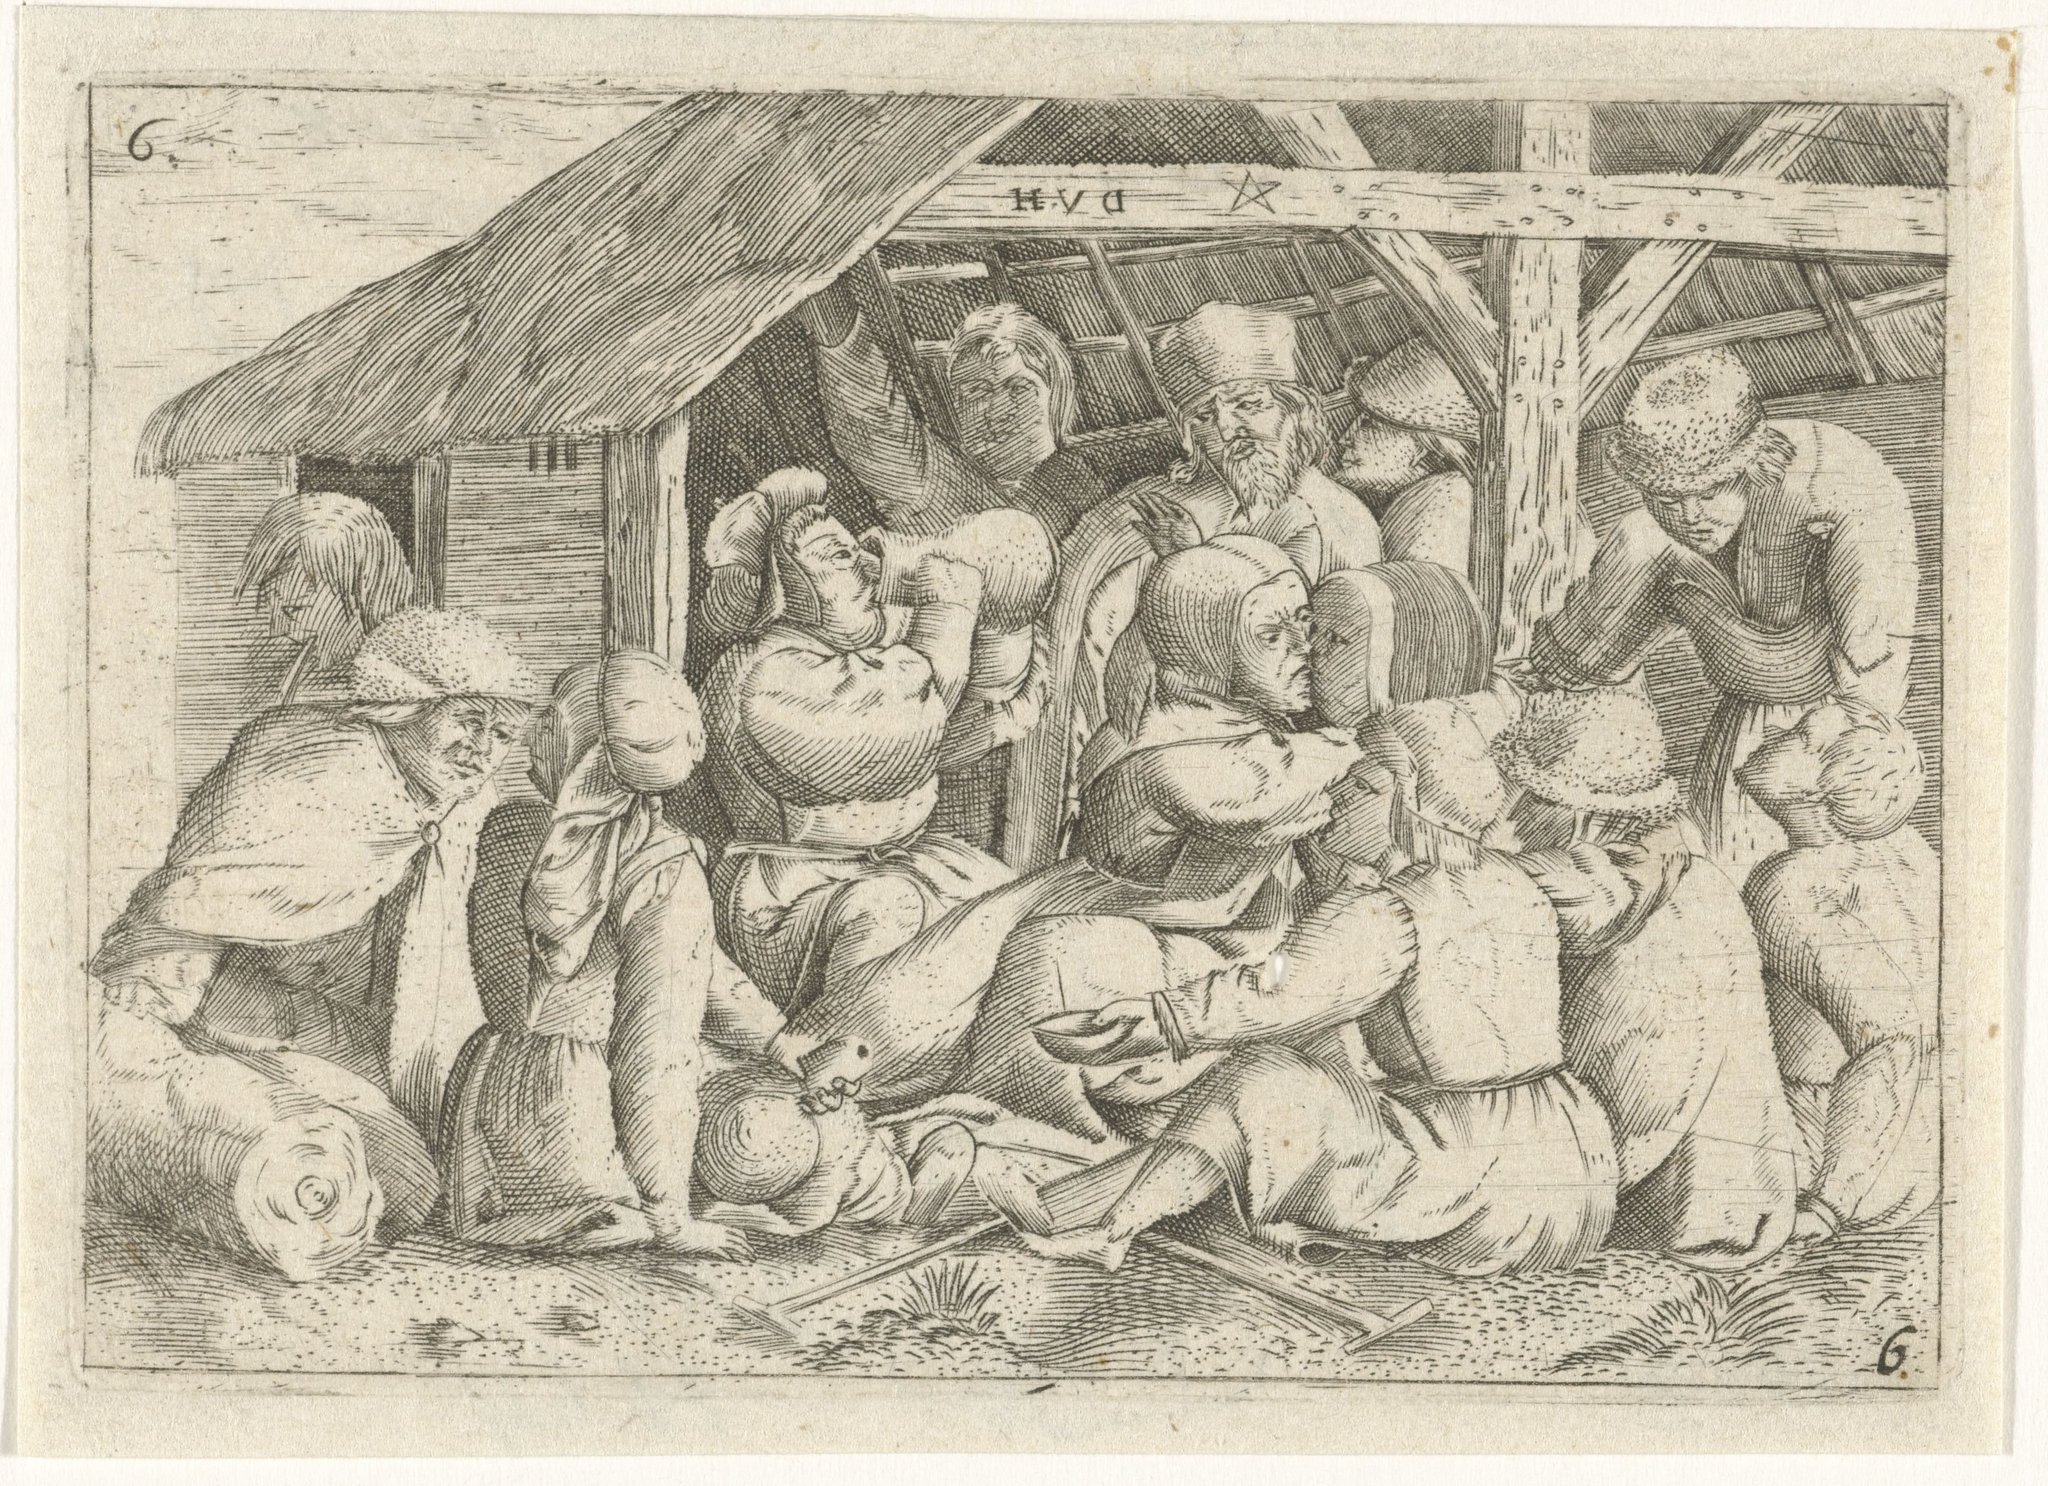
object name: print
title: Bedelaars bij een maaltijd in een hut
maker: dirk van hoogstraten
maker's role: painter, print maker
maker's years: 1596-1640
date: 1606-1640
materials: paper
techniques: engraving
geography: northern netherlands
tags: crutches, vomiting, jar, jug (used as drinking-vessel), (family) meal, the poor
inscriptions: inscription: ‘B17 Les querelles de gueux/ no.7 der copiën’, collector's mark: Lugt 2228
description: Bij een hut zitten arme mensen en mensen met een beperking op de grond. Ze kijken naar etende en drinkende figuren. Een dikke man zet een kruik aan zijn mond. In het midden een kussend paar. Links geeft een figuur over uit het raam. Kopie in spiegelbeeld naar een prent van Cornelis Massijs.